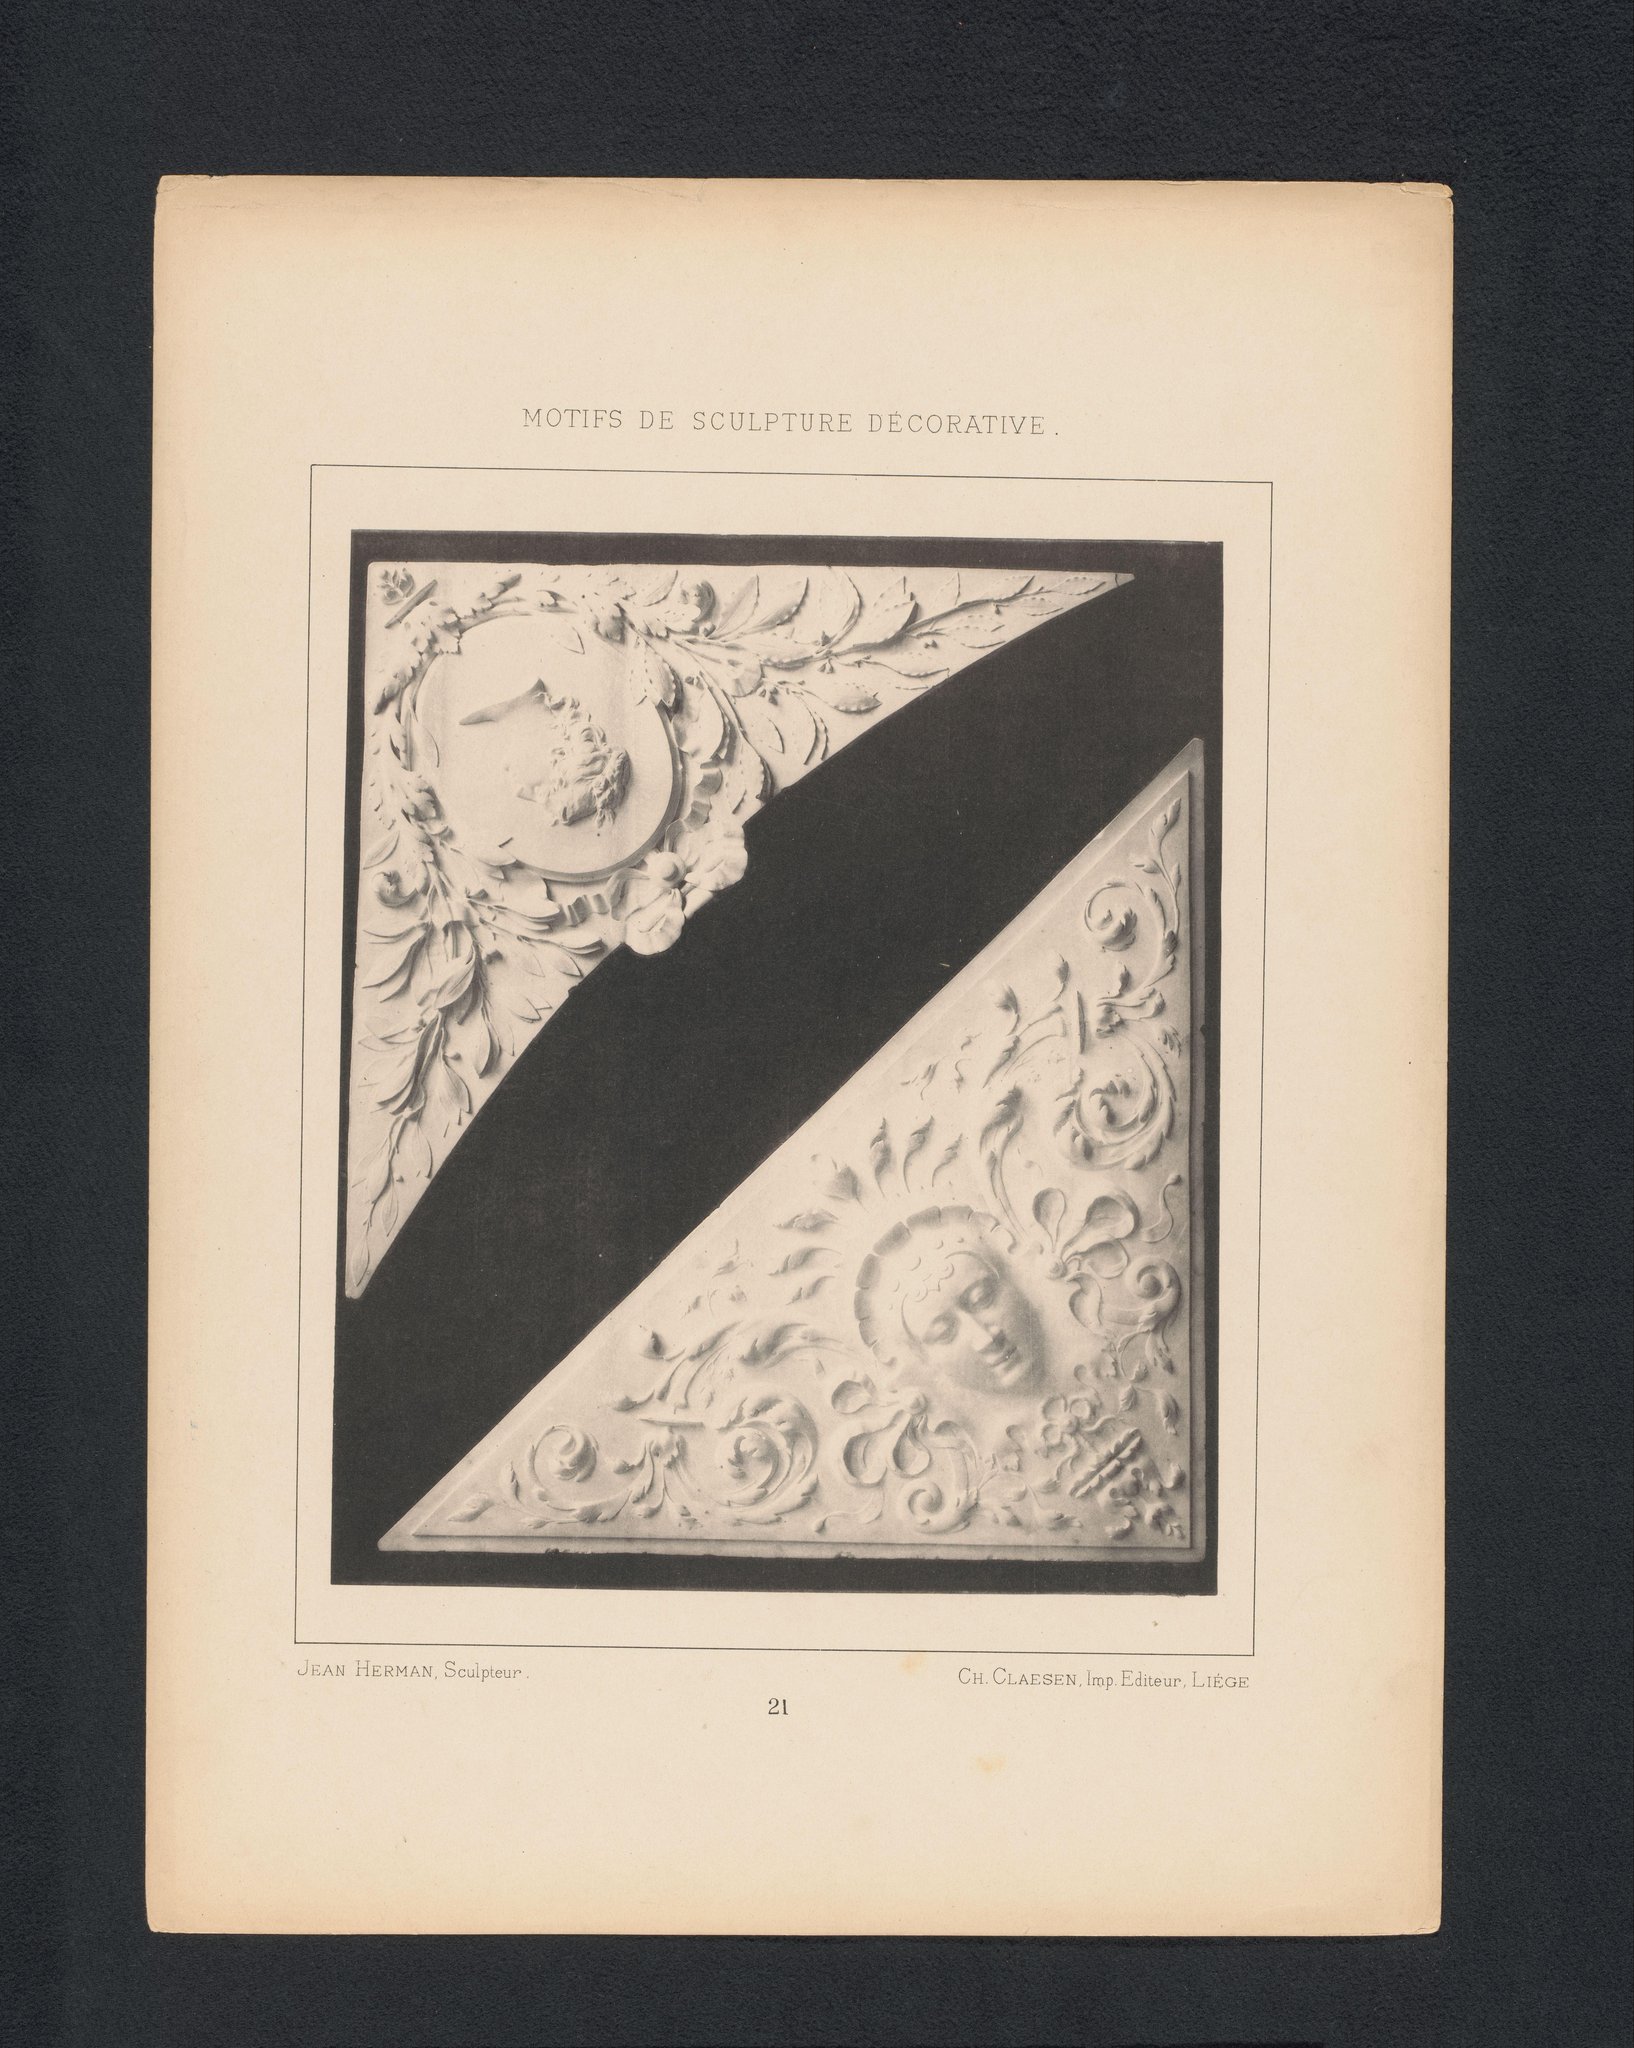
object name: photomechanical print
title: Twee reliëfs met bladranken en gezichten, gebeeldhouwd door Jean Herman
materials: paper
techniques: photograph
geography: liège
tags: face, foliage, tendrils, branches ~ ornament, sculpture (+ relief ~ sculpture)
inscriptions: inscription: ‘Jean Herman, Sculpteur.’, number: ‘21’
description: Deze prent maakt deel uit van een omslag met 28 prenten en een titelblad.